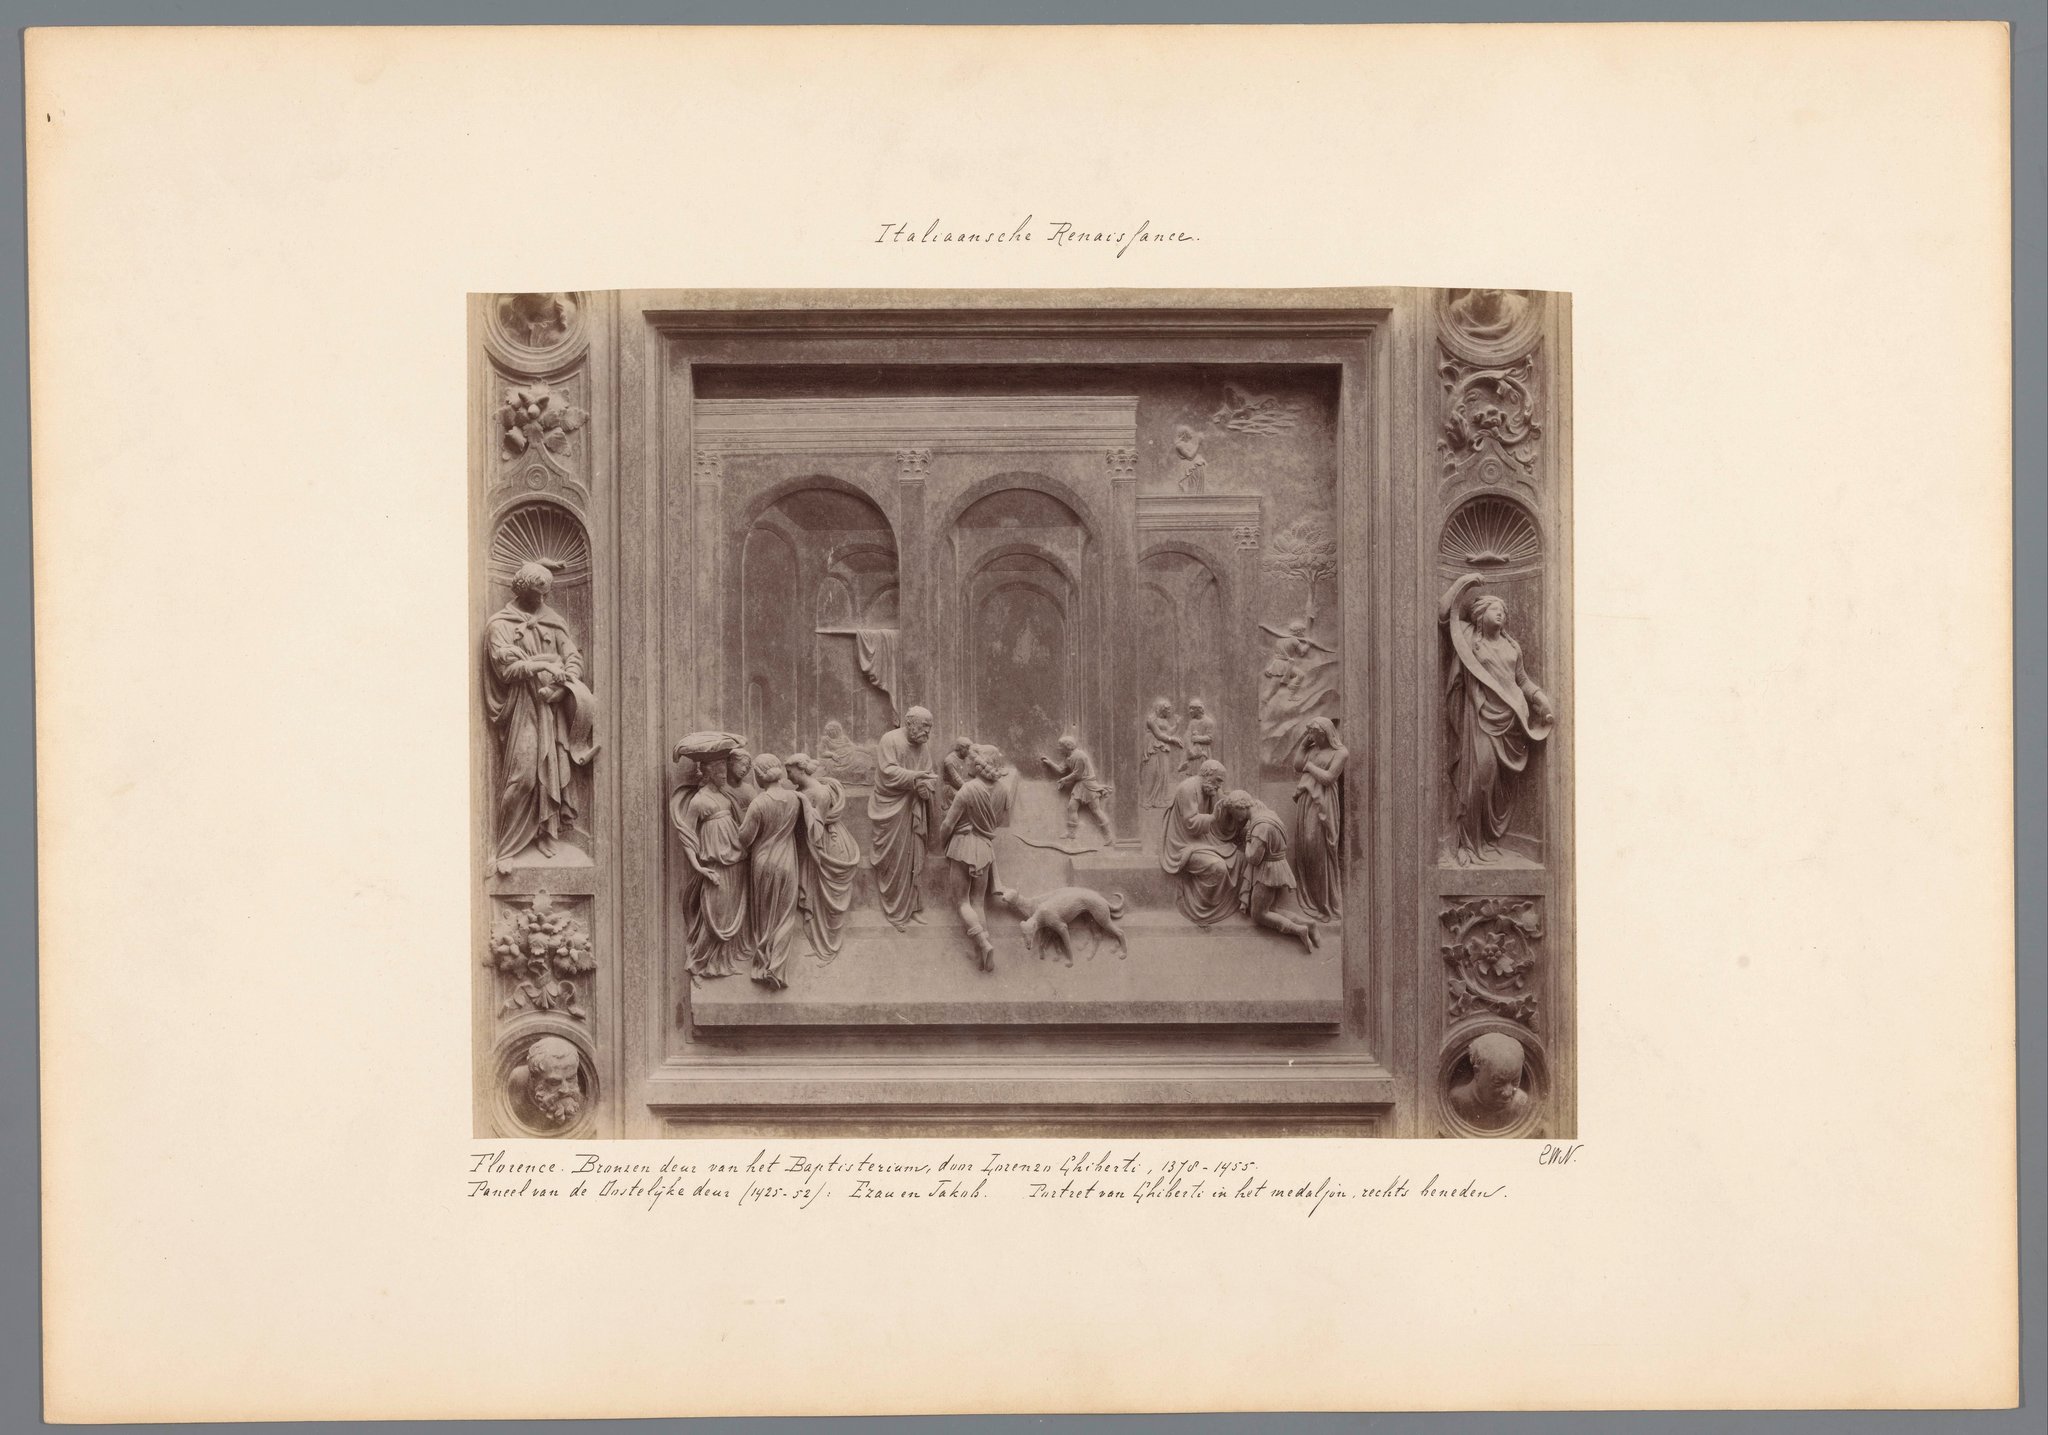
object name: photograph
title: Paneel van de bronzen deur van het Baptisterium te Florence, voorstellende Jakob en Ezau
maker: Anonymous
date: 1870-1900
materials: cardboard, photographic support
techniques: albumen print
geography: florence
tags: ornaments ~ art, jacob and esau are reconciled (genesis 33), ornament derived from plant forms, sculpture (+ relief ~ sculpture)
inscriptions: inscription: ‘CWN.’, collector's mark: ‘KUNSTNIJVERHEIDSCHOOL QUELLINUS AMSTERDAM FRANS HALSSTRAAT 14.’, inscription: ‘Italiaansche Renaissance. Florence. Bronzen deur van het Baptisterium, door Lorenzo Ghiberti, 1378-1455. Paneel van de Oostelijke deur (1425-52): Ezau en Jakob. Portret van Ghiberti in het medaljon rechts beneden.’, collector's mark: ‘INSTITUUT VOOR KUNST- NIJVERHEIDSONDERWIJS GABRIËL METSUSTRAAT No. 16. AMSTERDAM’